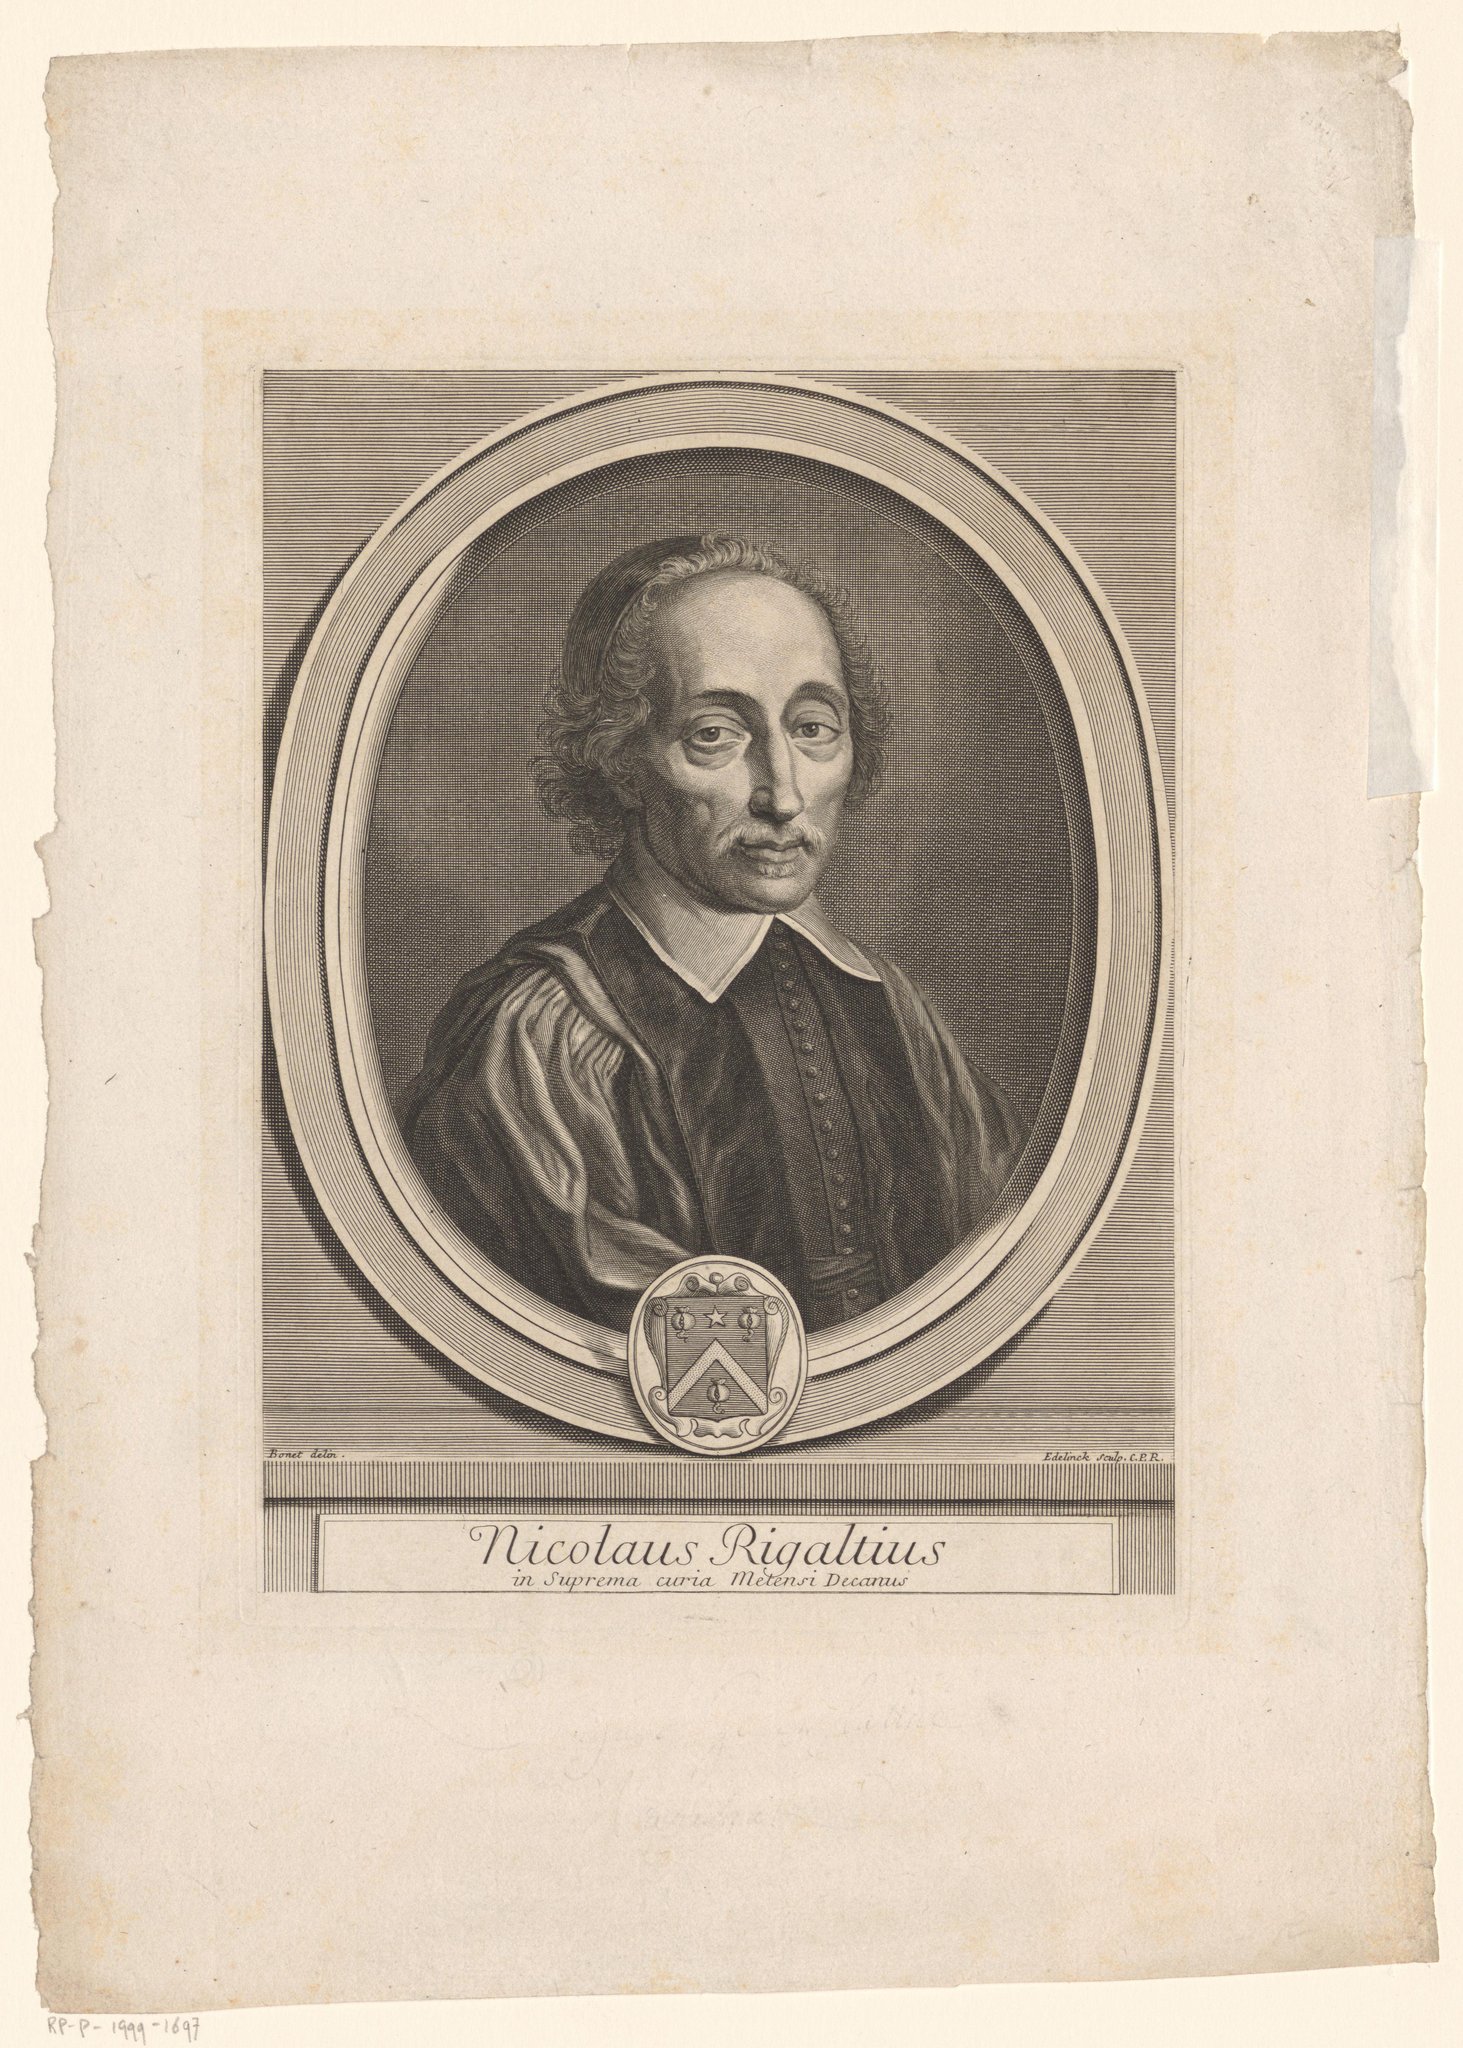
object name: print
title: Portret van Nicolas Rigault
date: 1650-1707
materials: paper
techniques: engraving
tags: paris, historical persons, armorial bearing, heraldry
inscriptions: collector's mark: Lugt 2228